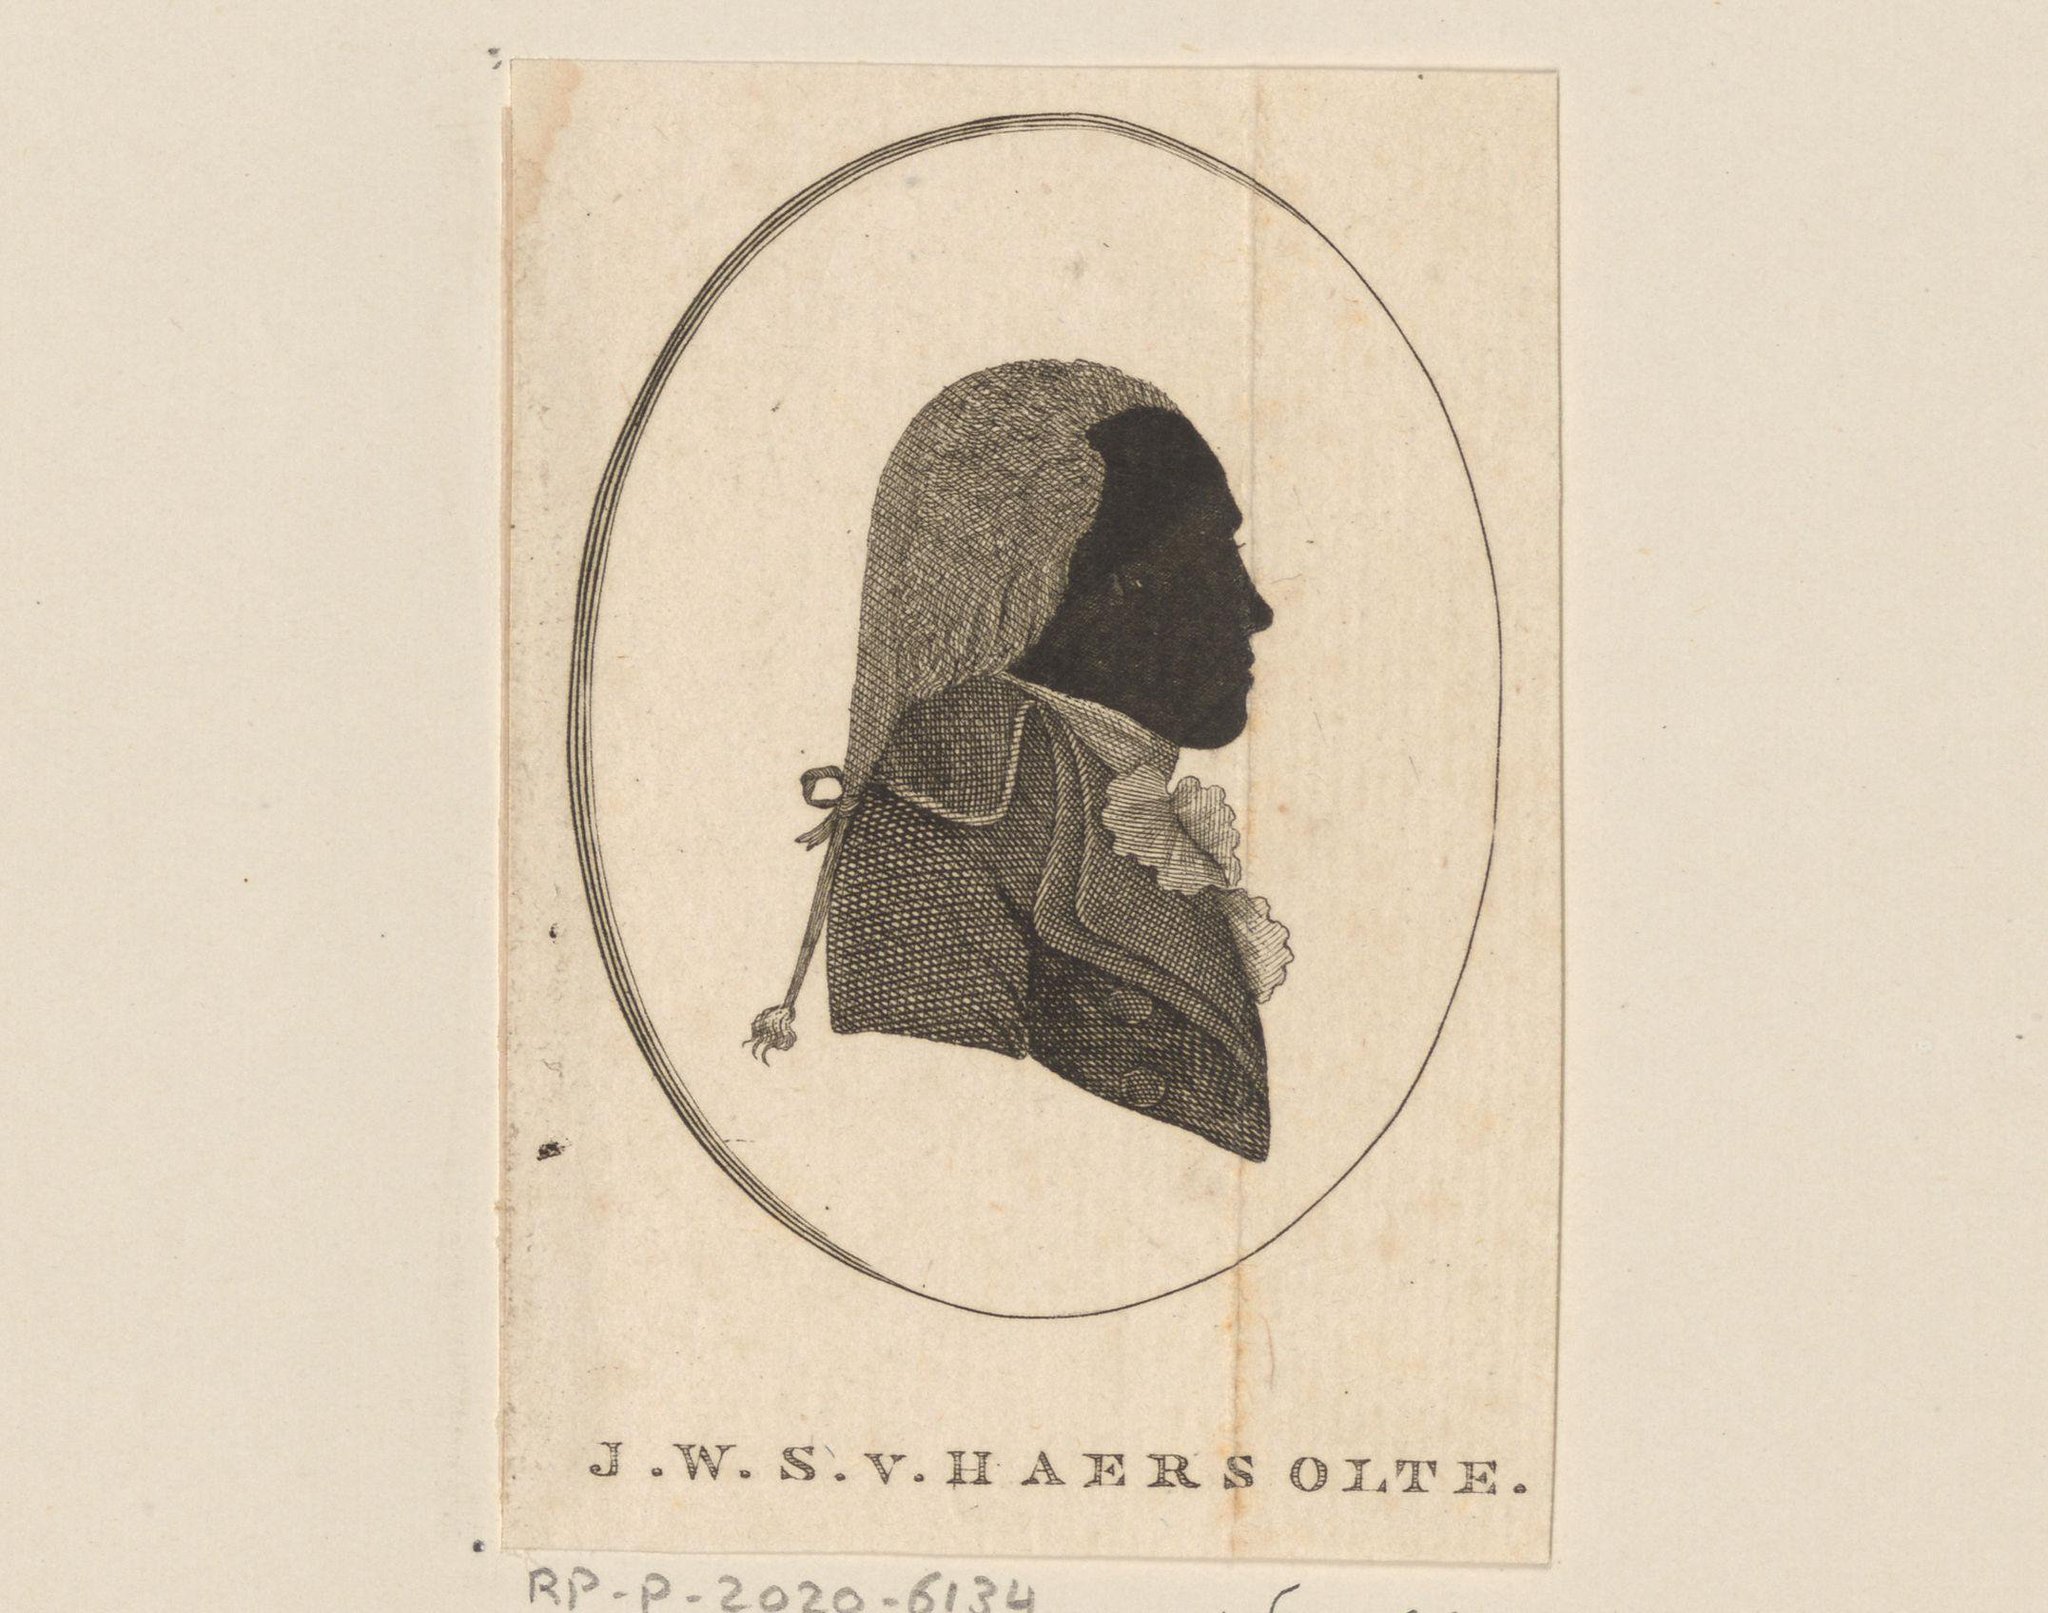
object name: book illustration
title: Silhouetportret van Johan Willem Simon van Haersolte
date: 1799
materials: paper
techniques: etching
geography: amsterdam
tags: historical persons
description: Prent uit: Rogge, Cornelis. Geschiedenis der staatsregeling, voor het Bataafsche volk. Amsterdam: Johannes Allart, 1799.